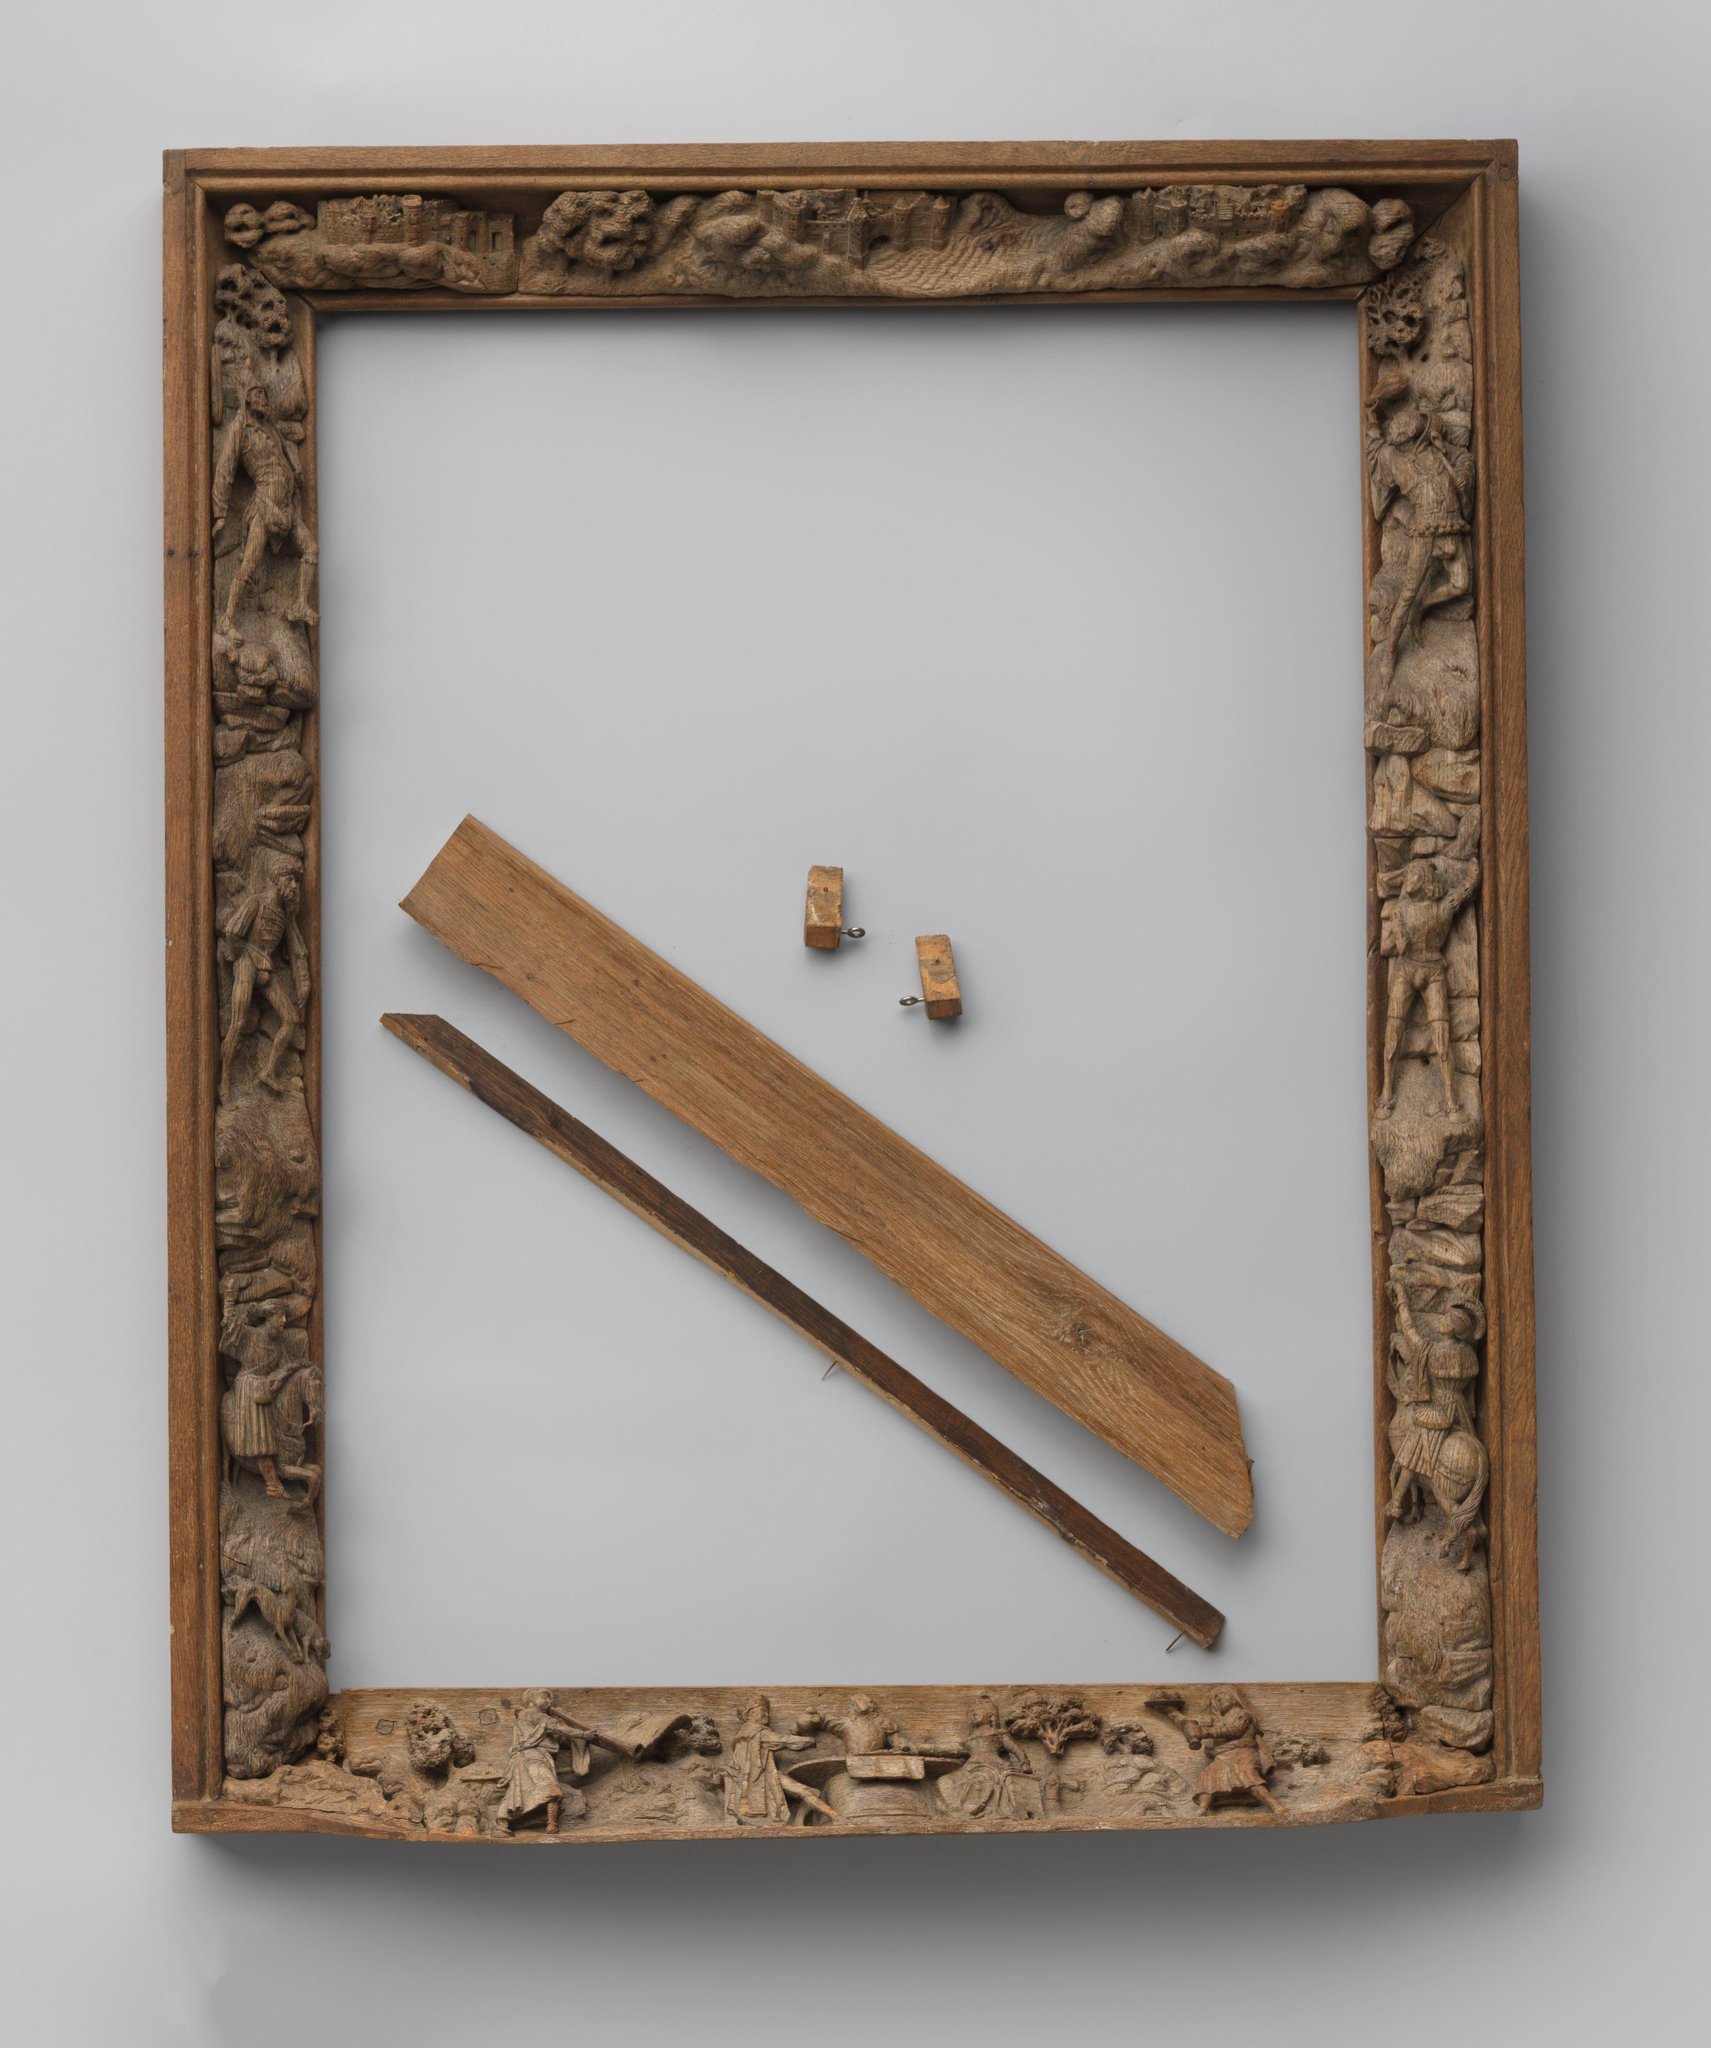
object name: sculpture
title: Onderdeel van houten profiellijst met beeldhouwwerk.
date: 1515-1520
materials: wood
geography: antwerp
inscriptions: annotation: ‘[...]’, annotation: ‘99’, label: ‘RBK 1966-6’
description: Onderdeel van een houten schilderijlijst met figurale voorstellingen. Op het onderdeel speelt zich een eetscène af te midden van rotsen en bomen.